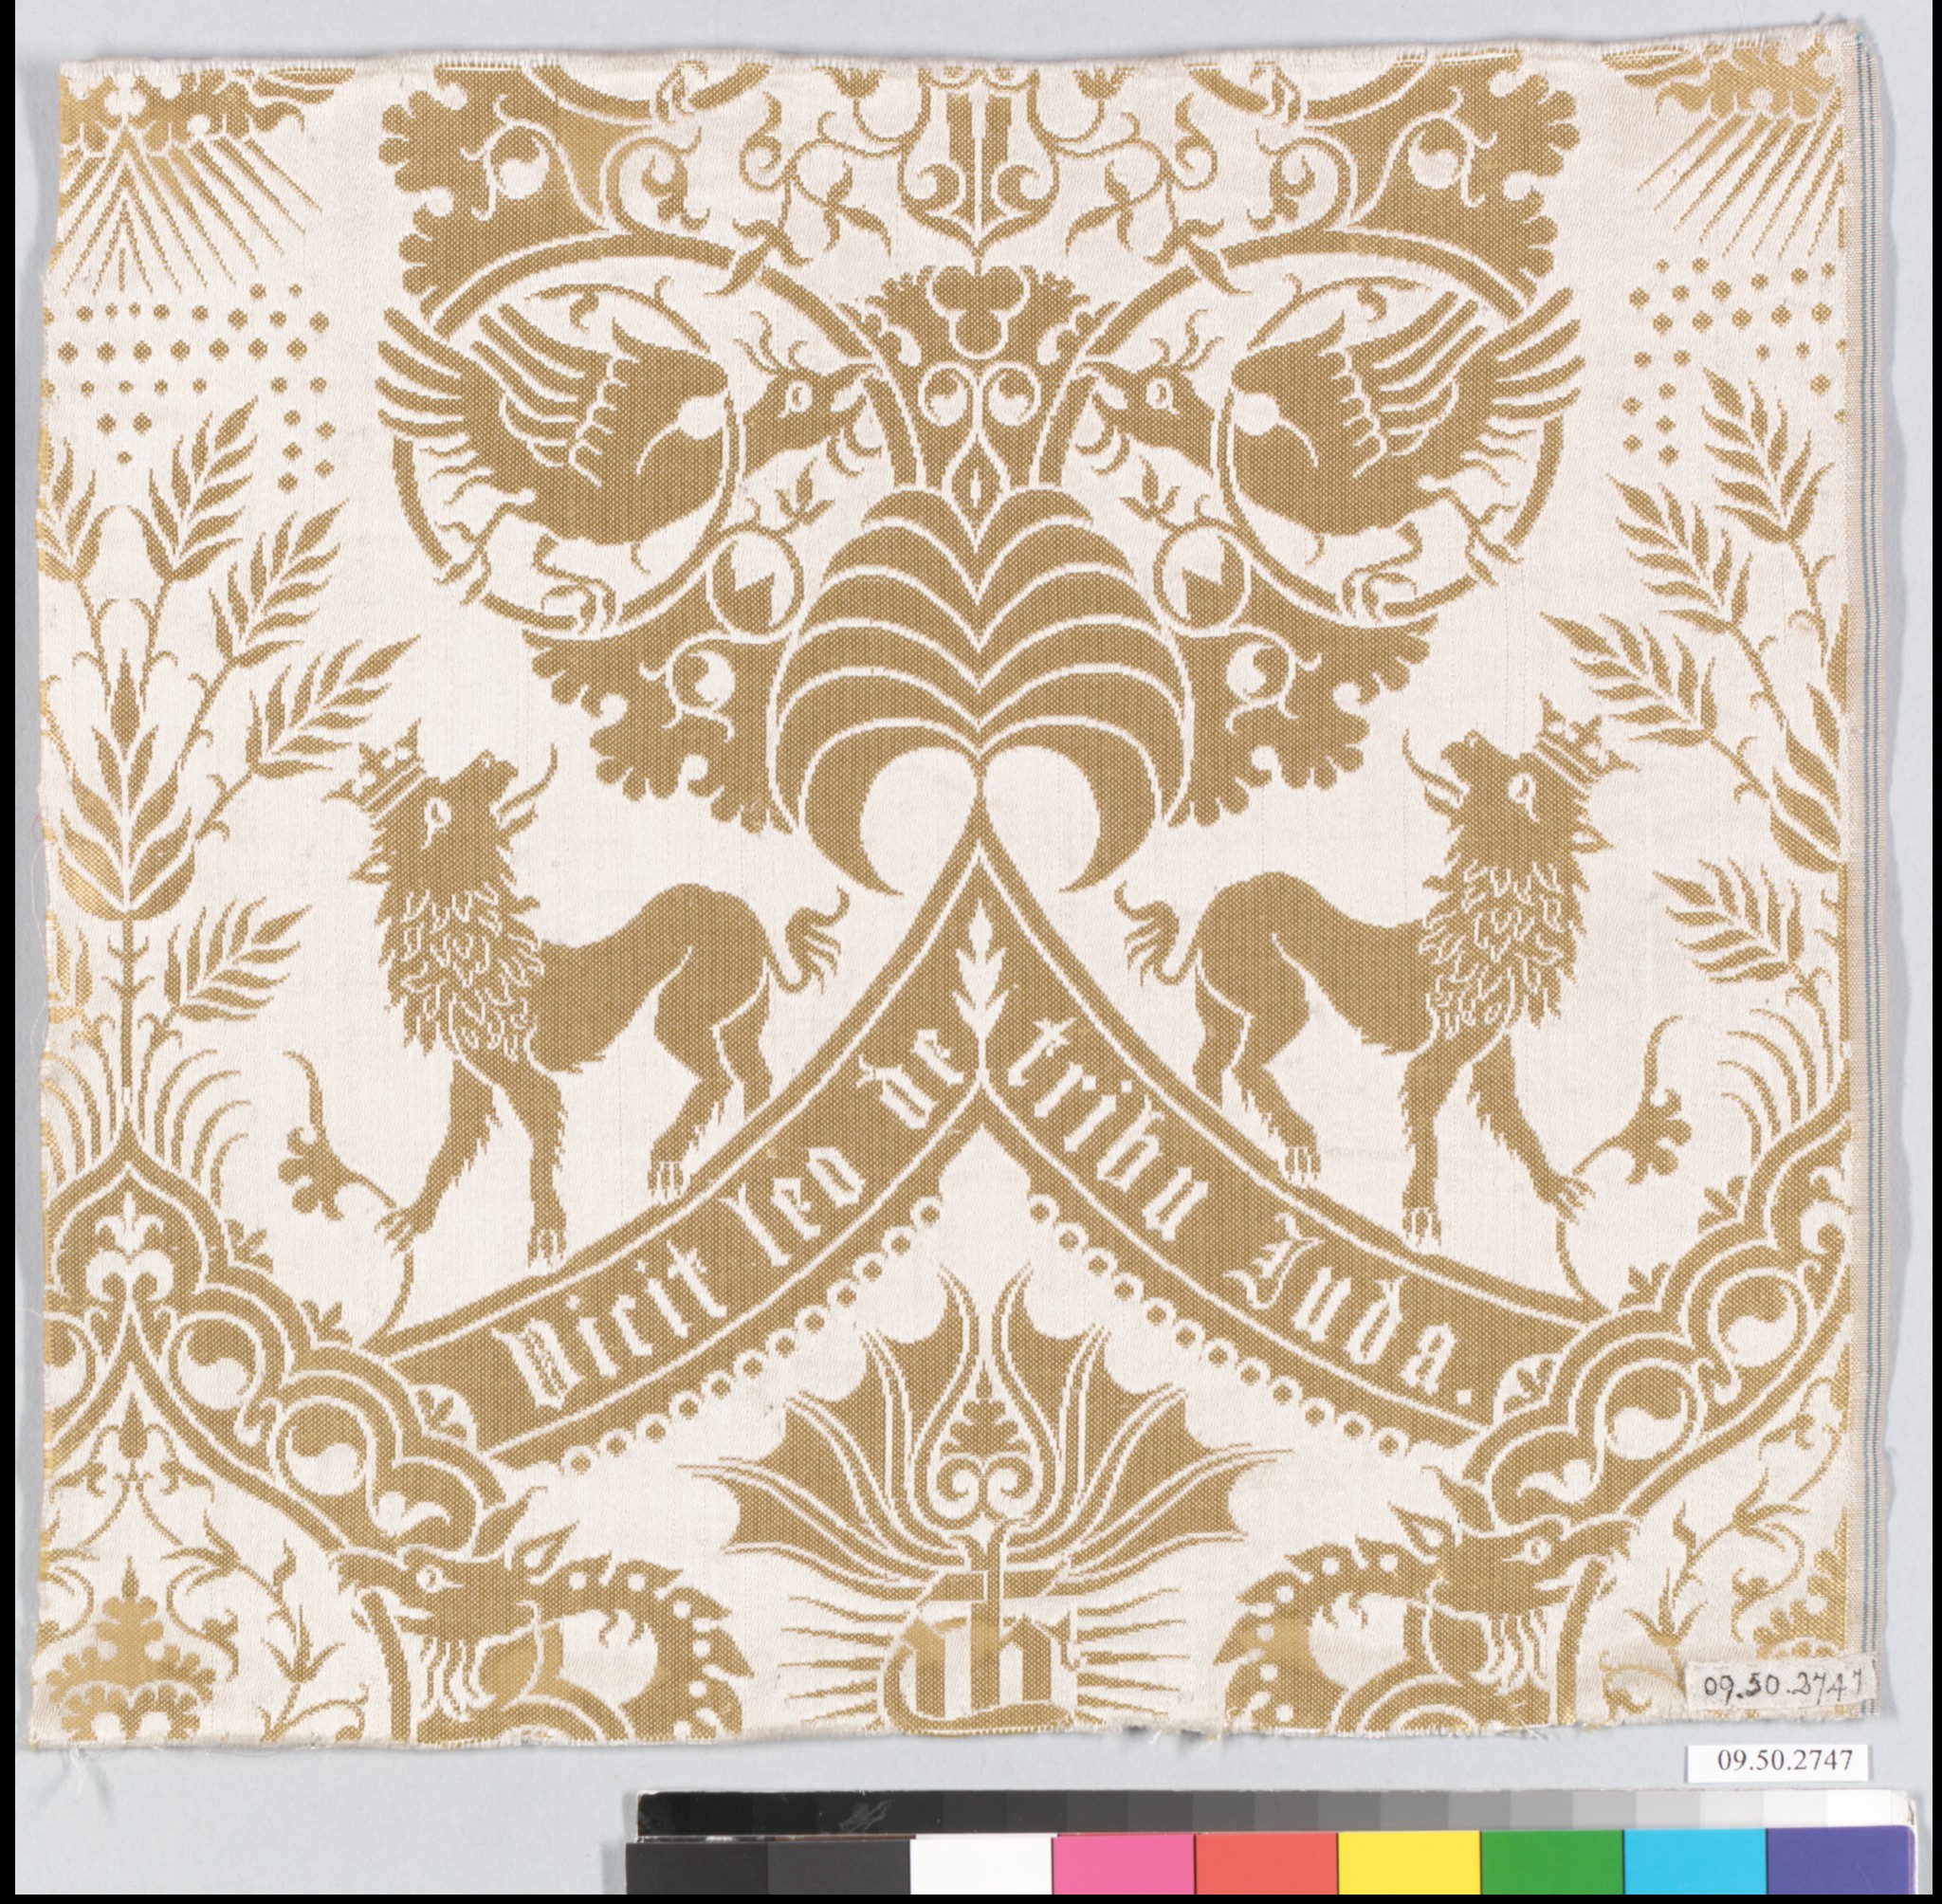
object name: piece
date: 1801-1900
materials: silk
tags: animals,birds,leaves,coat of arms